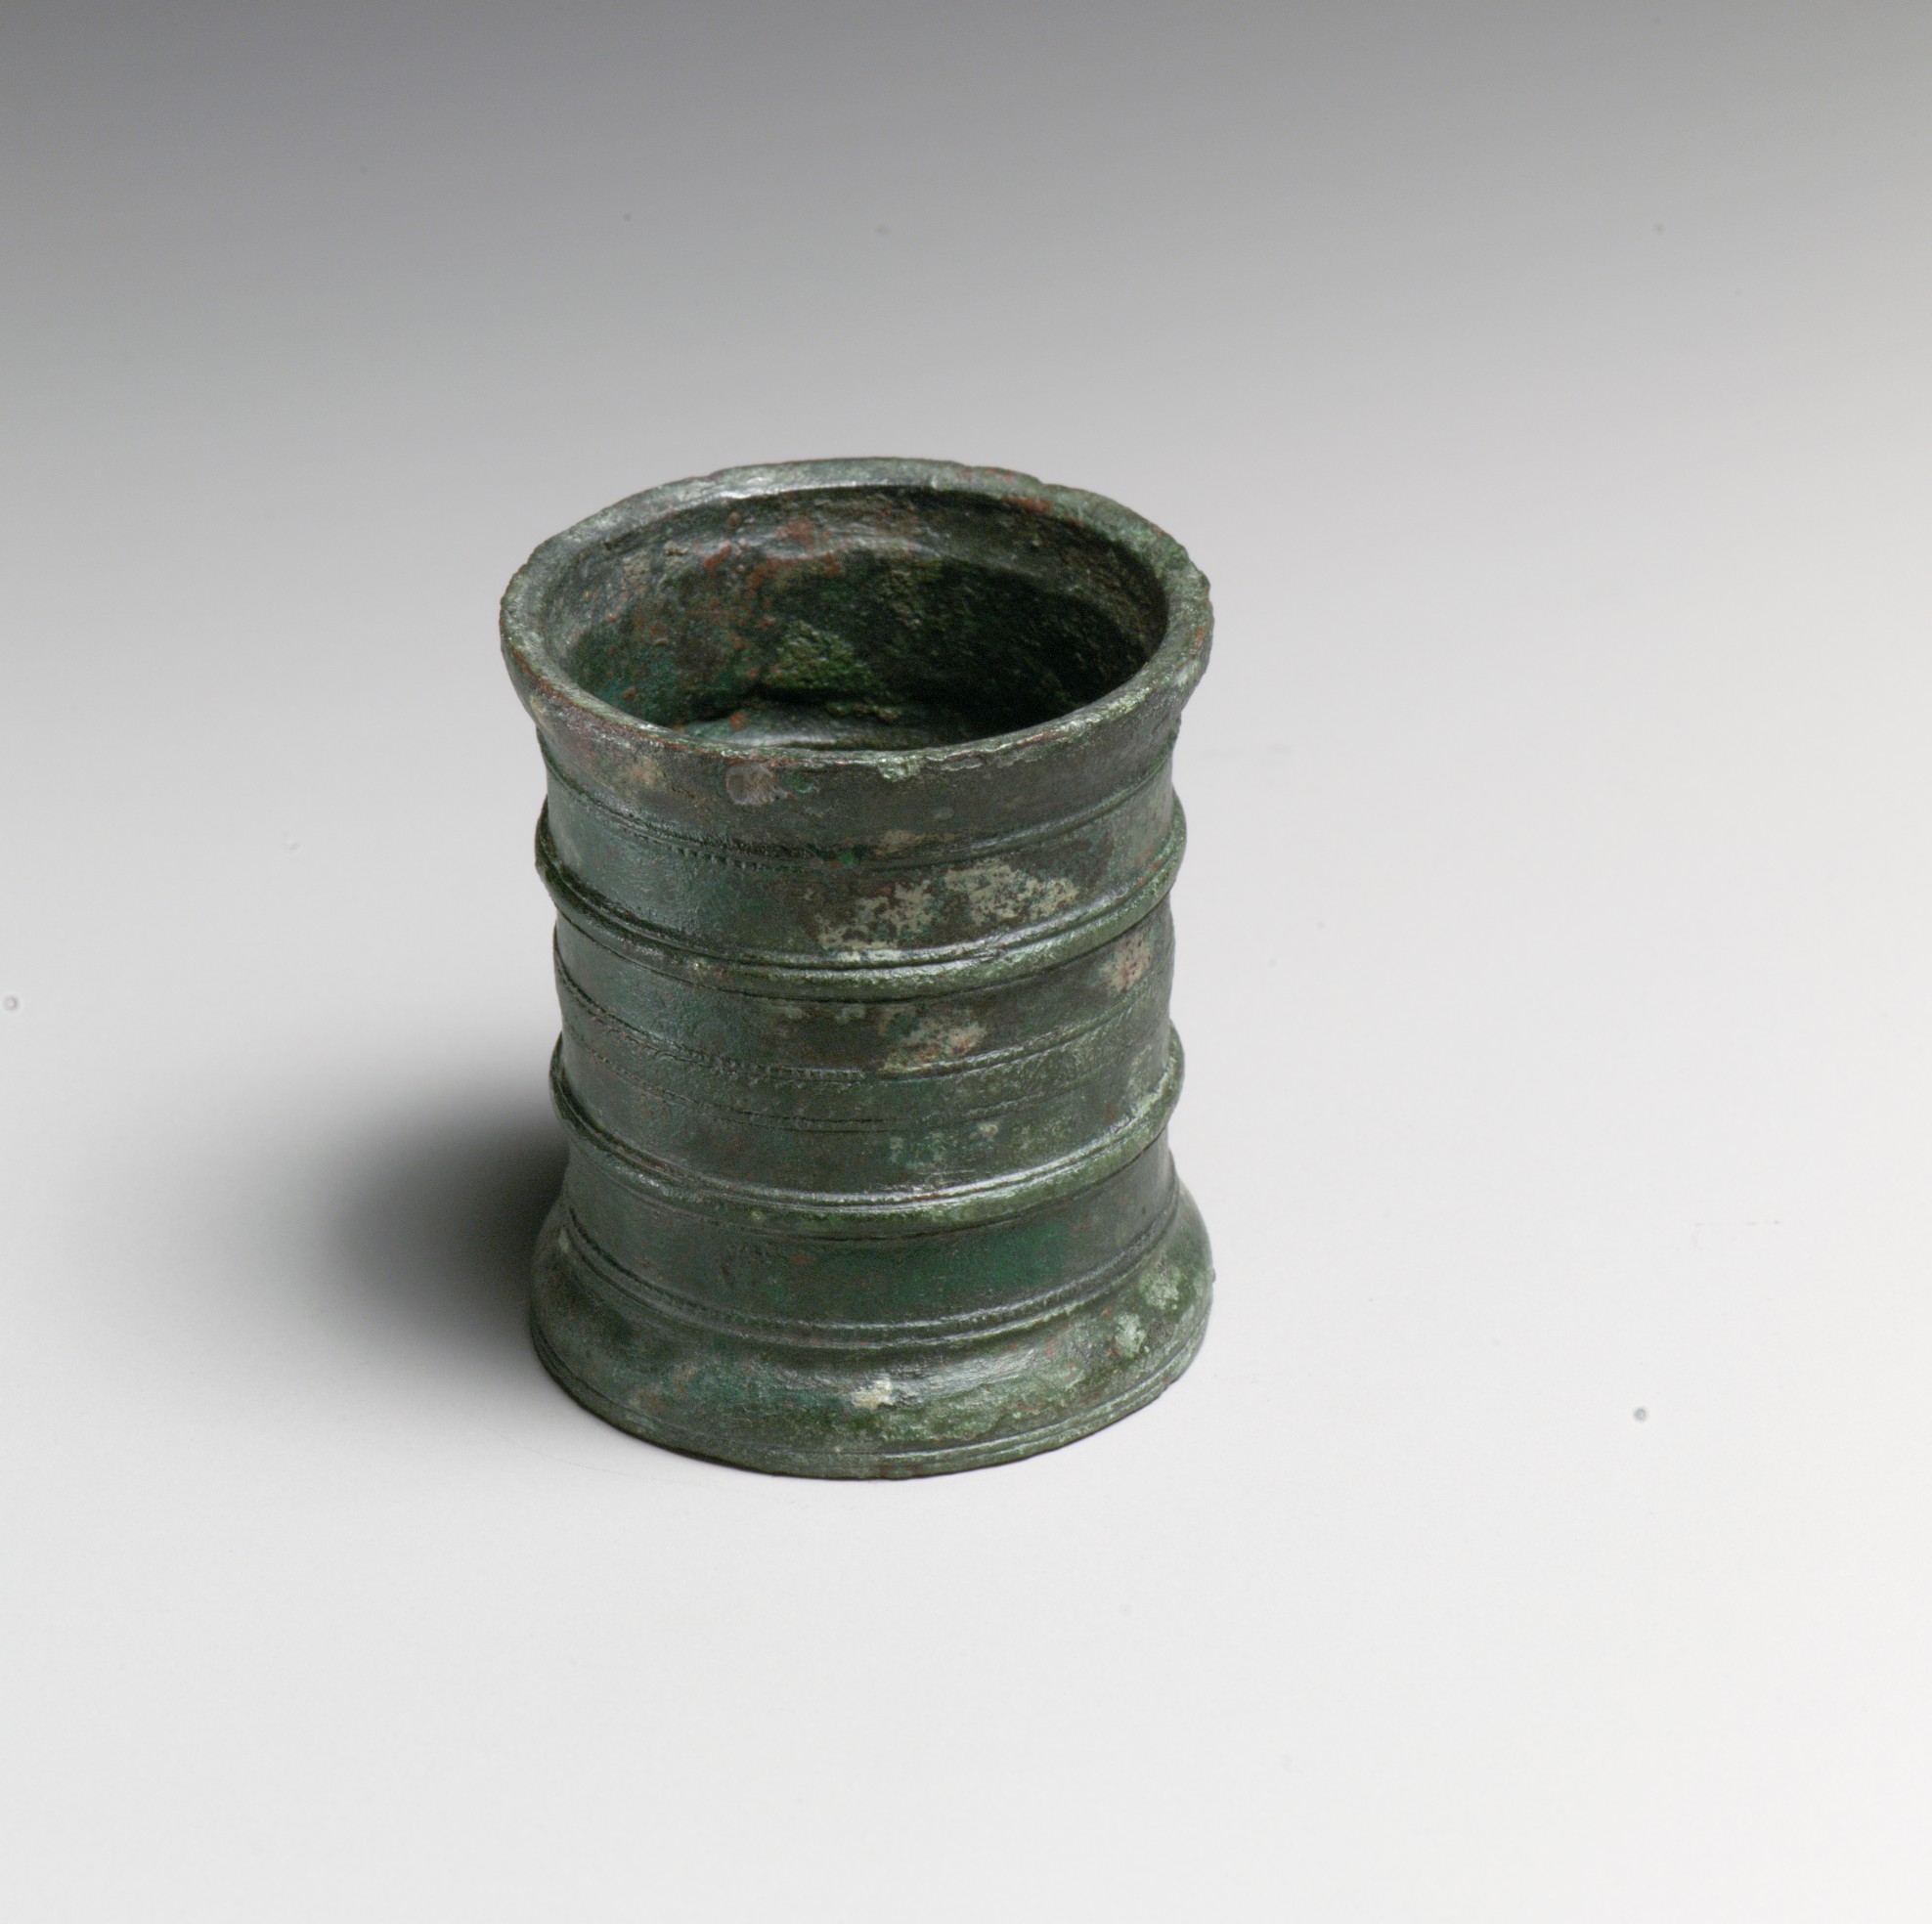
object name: cup, cylindrical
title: Bronze cylindrical cup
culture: roman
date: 1-200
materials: bronze